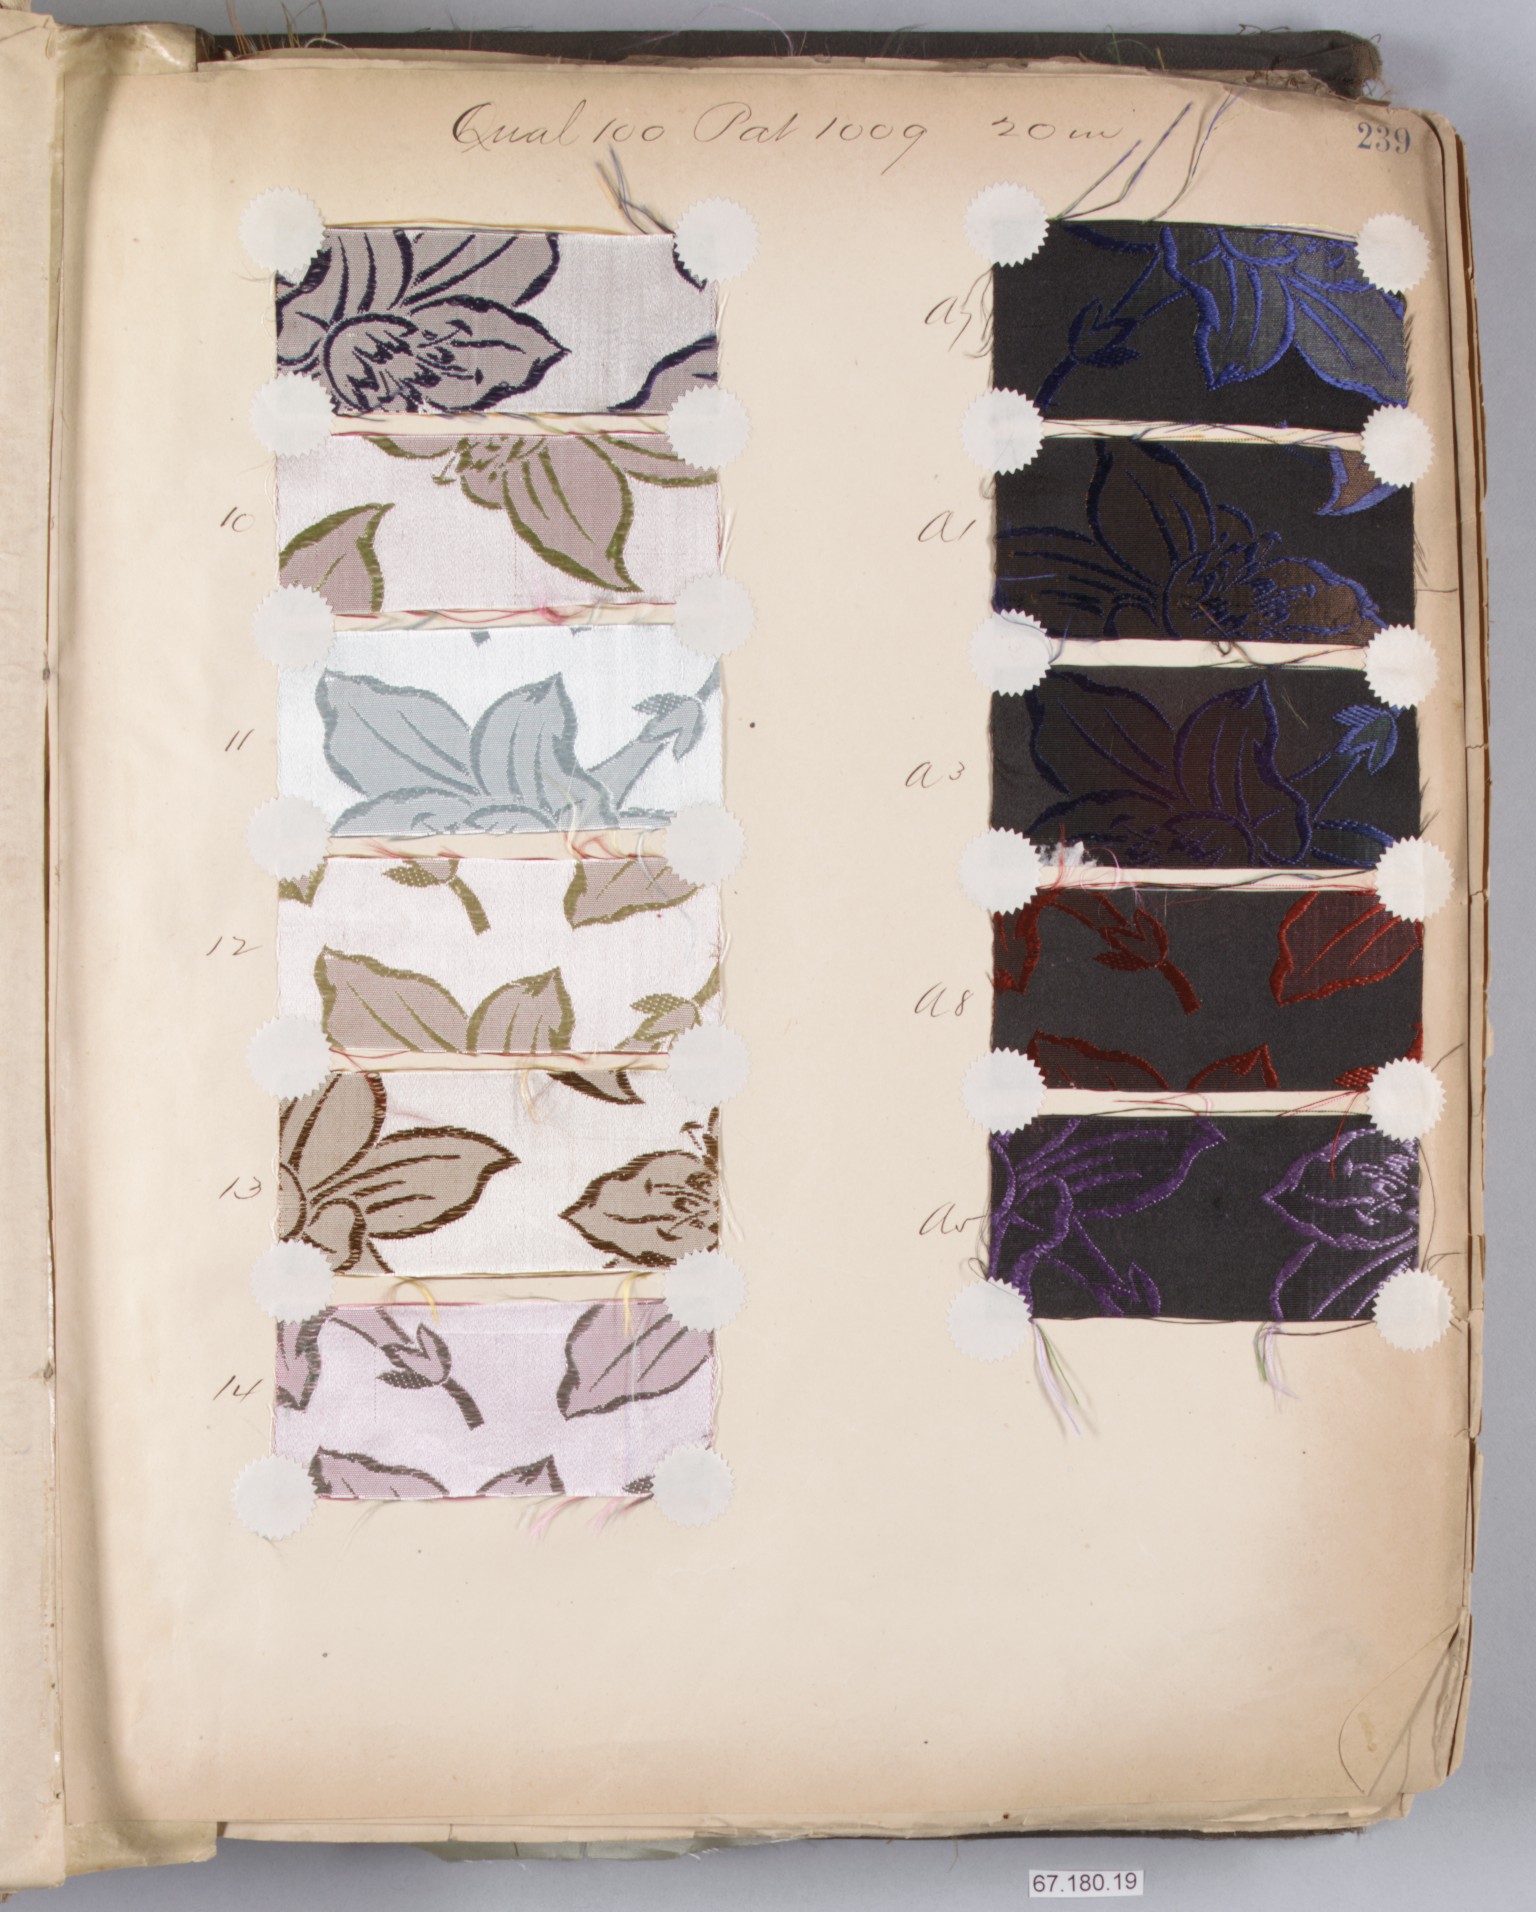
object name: sample book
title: Textile Sample Book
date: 1890-1899